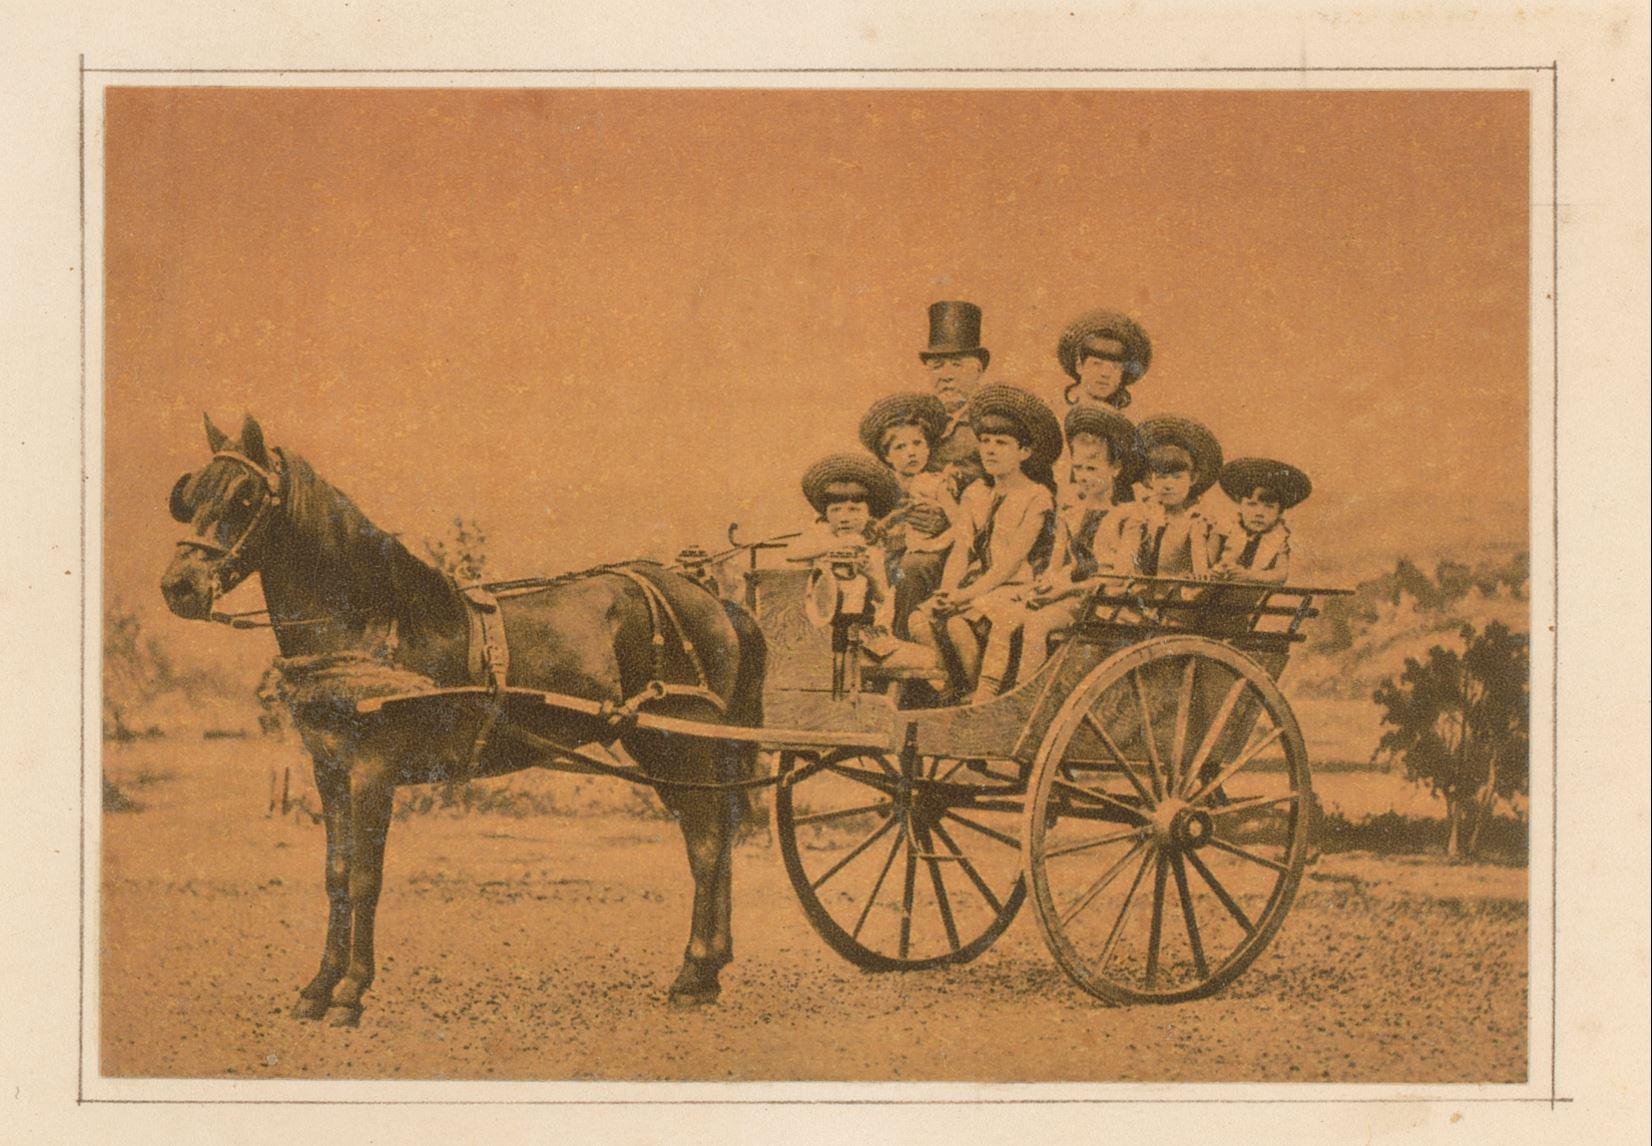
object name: album leaf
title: Ferdinand de Lesseps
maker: Anonymous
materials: paper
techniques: rotogravure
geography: france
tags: writer, poet, author, france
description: Deze prent maakt deel uit van een album.